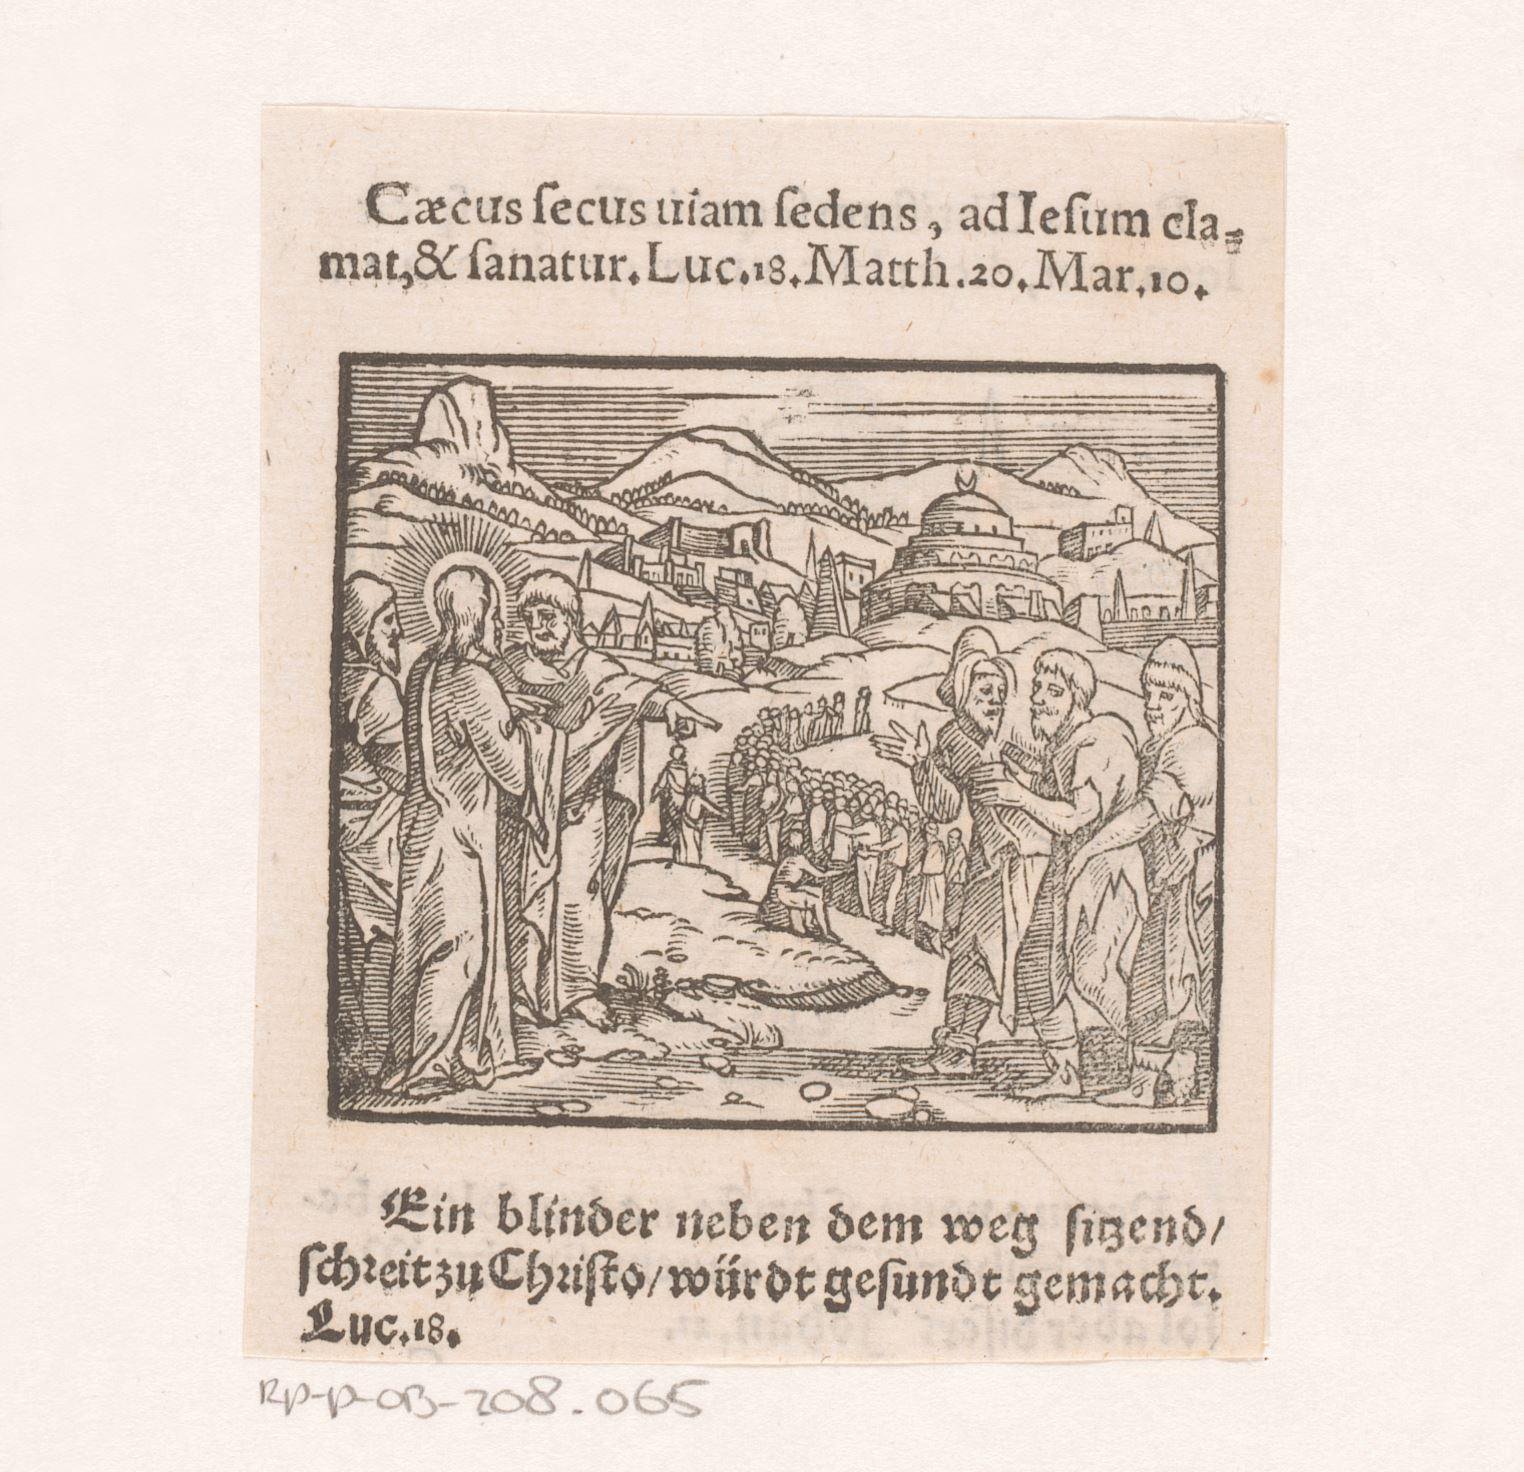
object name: print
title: Christus geneest de blinde Bartimeüs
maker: Anonymous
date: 1600-1699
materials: paper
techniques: letterpress printing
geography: netherlands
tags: healing of two blind men, or one (bartimaeus), sitting near jericho (matthew 20:29-34; mark 10:46-52; luke 18:35-43)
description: Christus geneest de blinde bedelaar Bartimeüs bij Jericho.